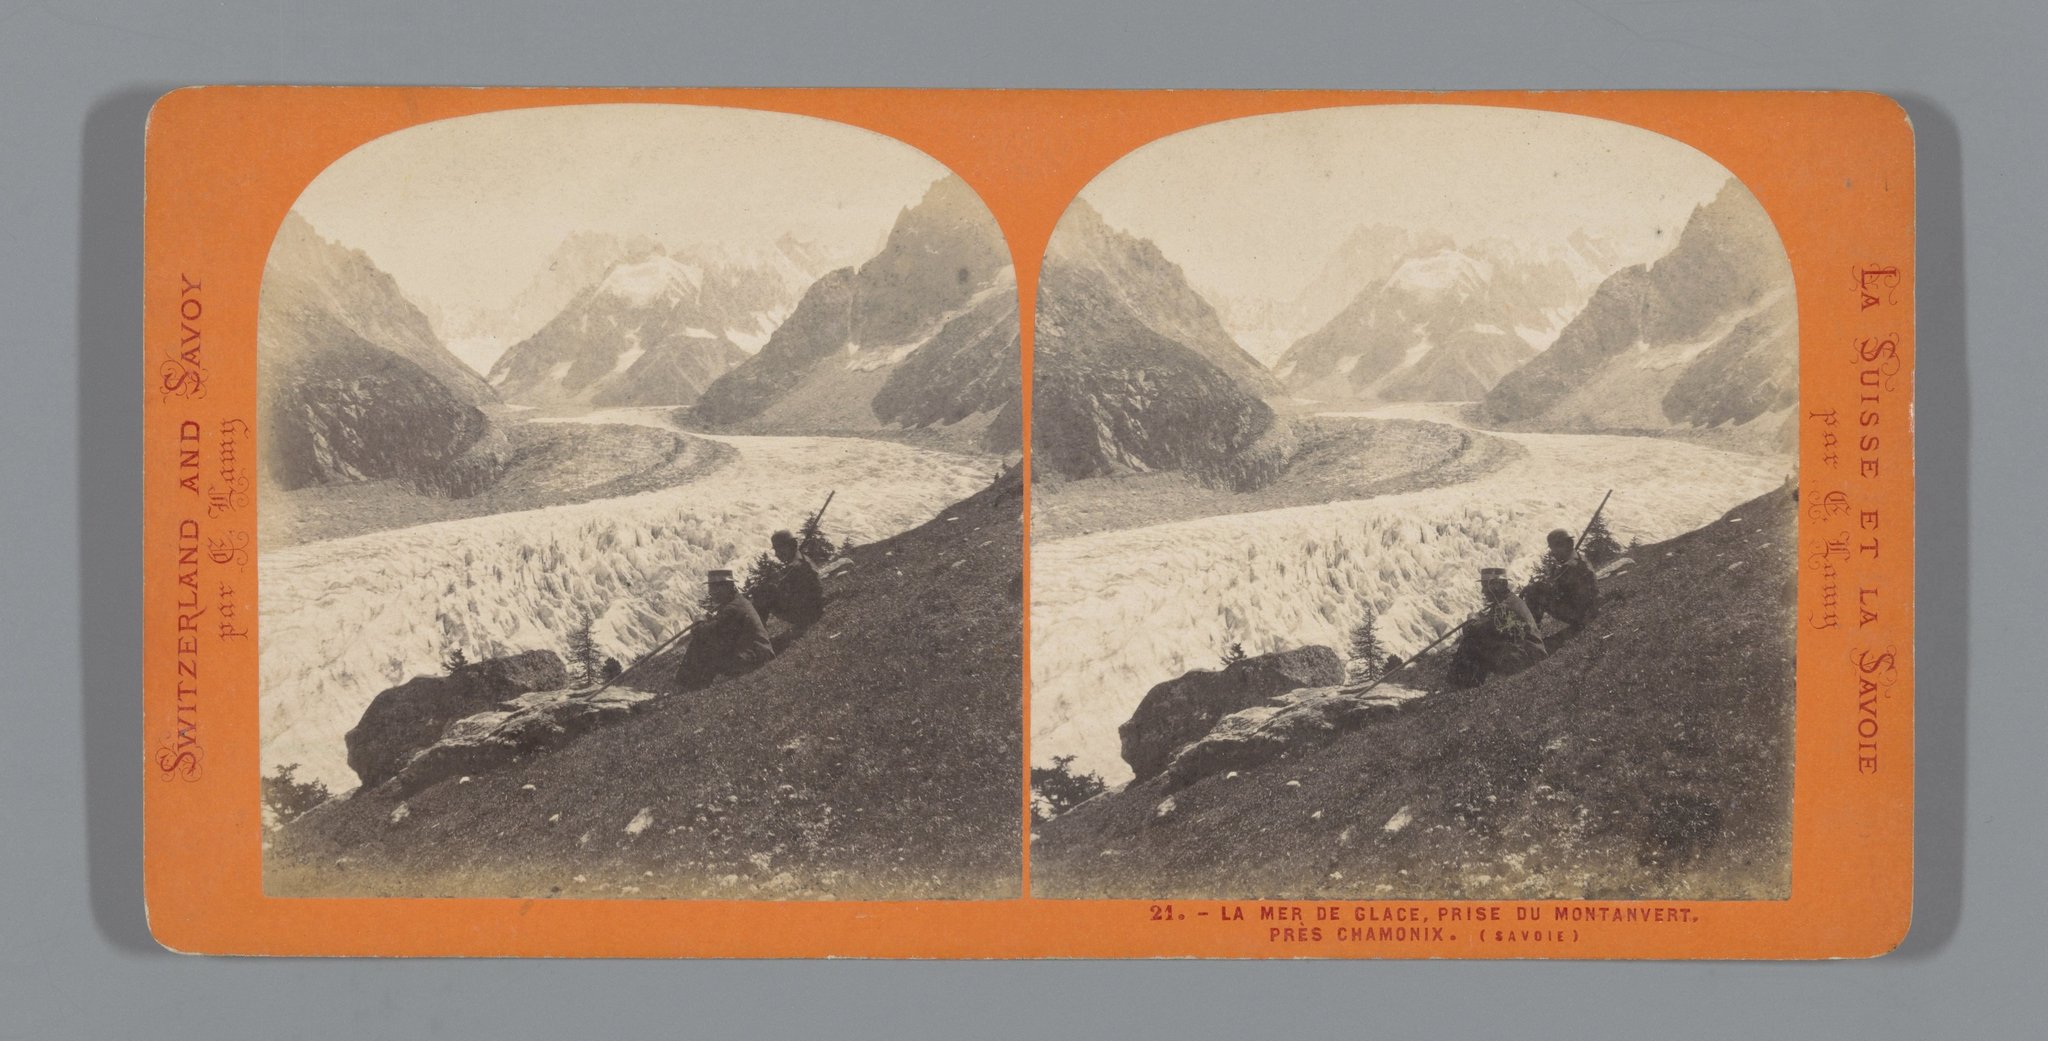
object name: stereograph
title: La Suisse et la Savoie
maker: ernest eléonor pierre lamy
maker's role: publisher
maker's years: 1828-1900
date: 1860-1880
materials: cardboard, photographic support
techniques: albumen print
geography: savoie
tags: glacier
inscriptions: number: ‘21.’